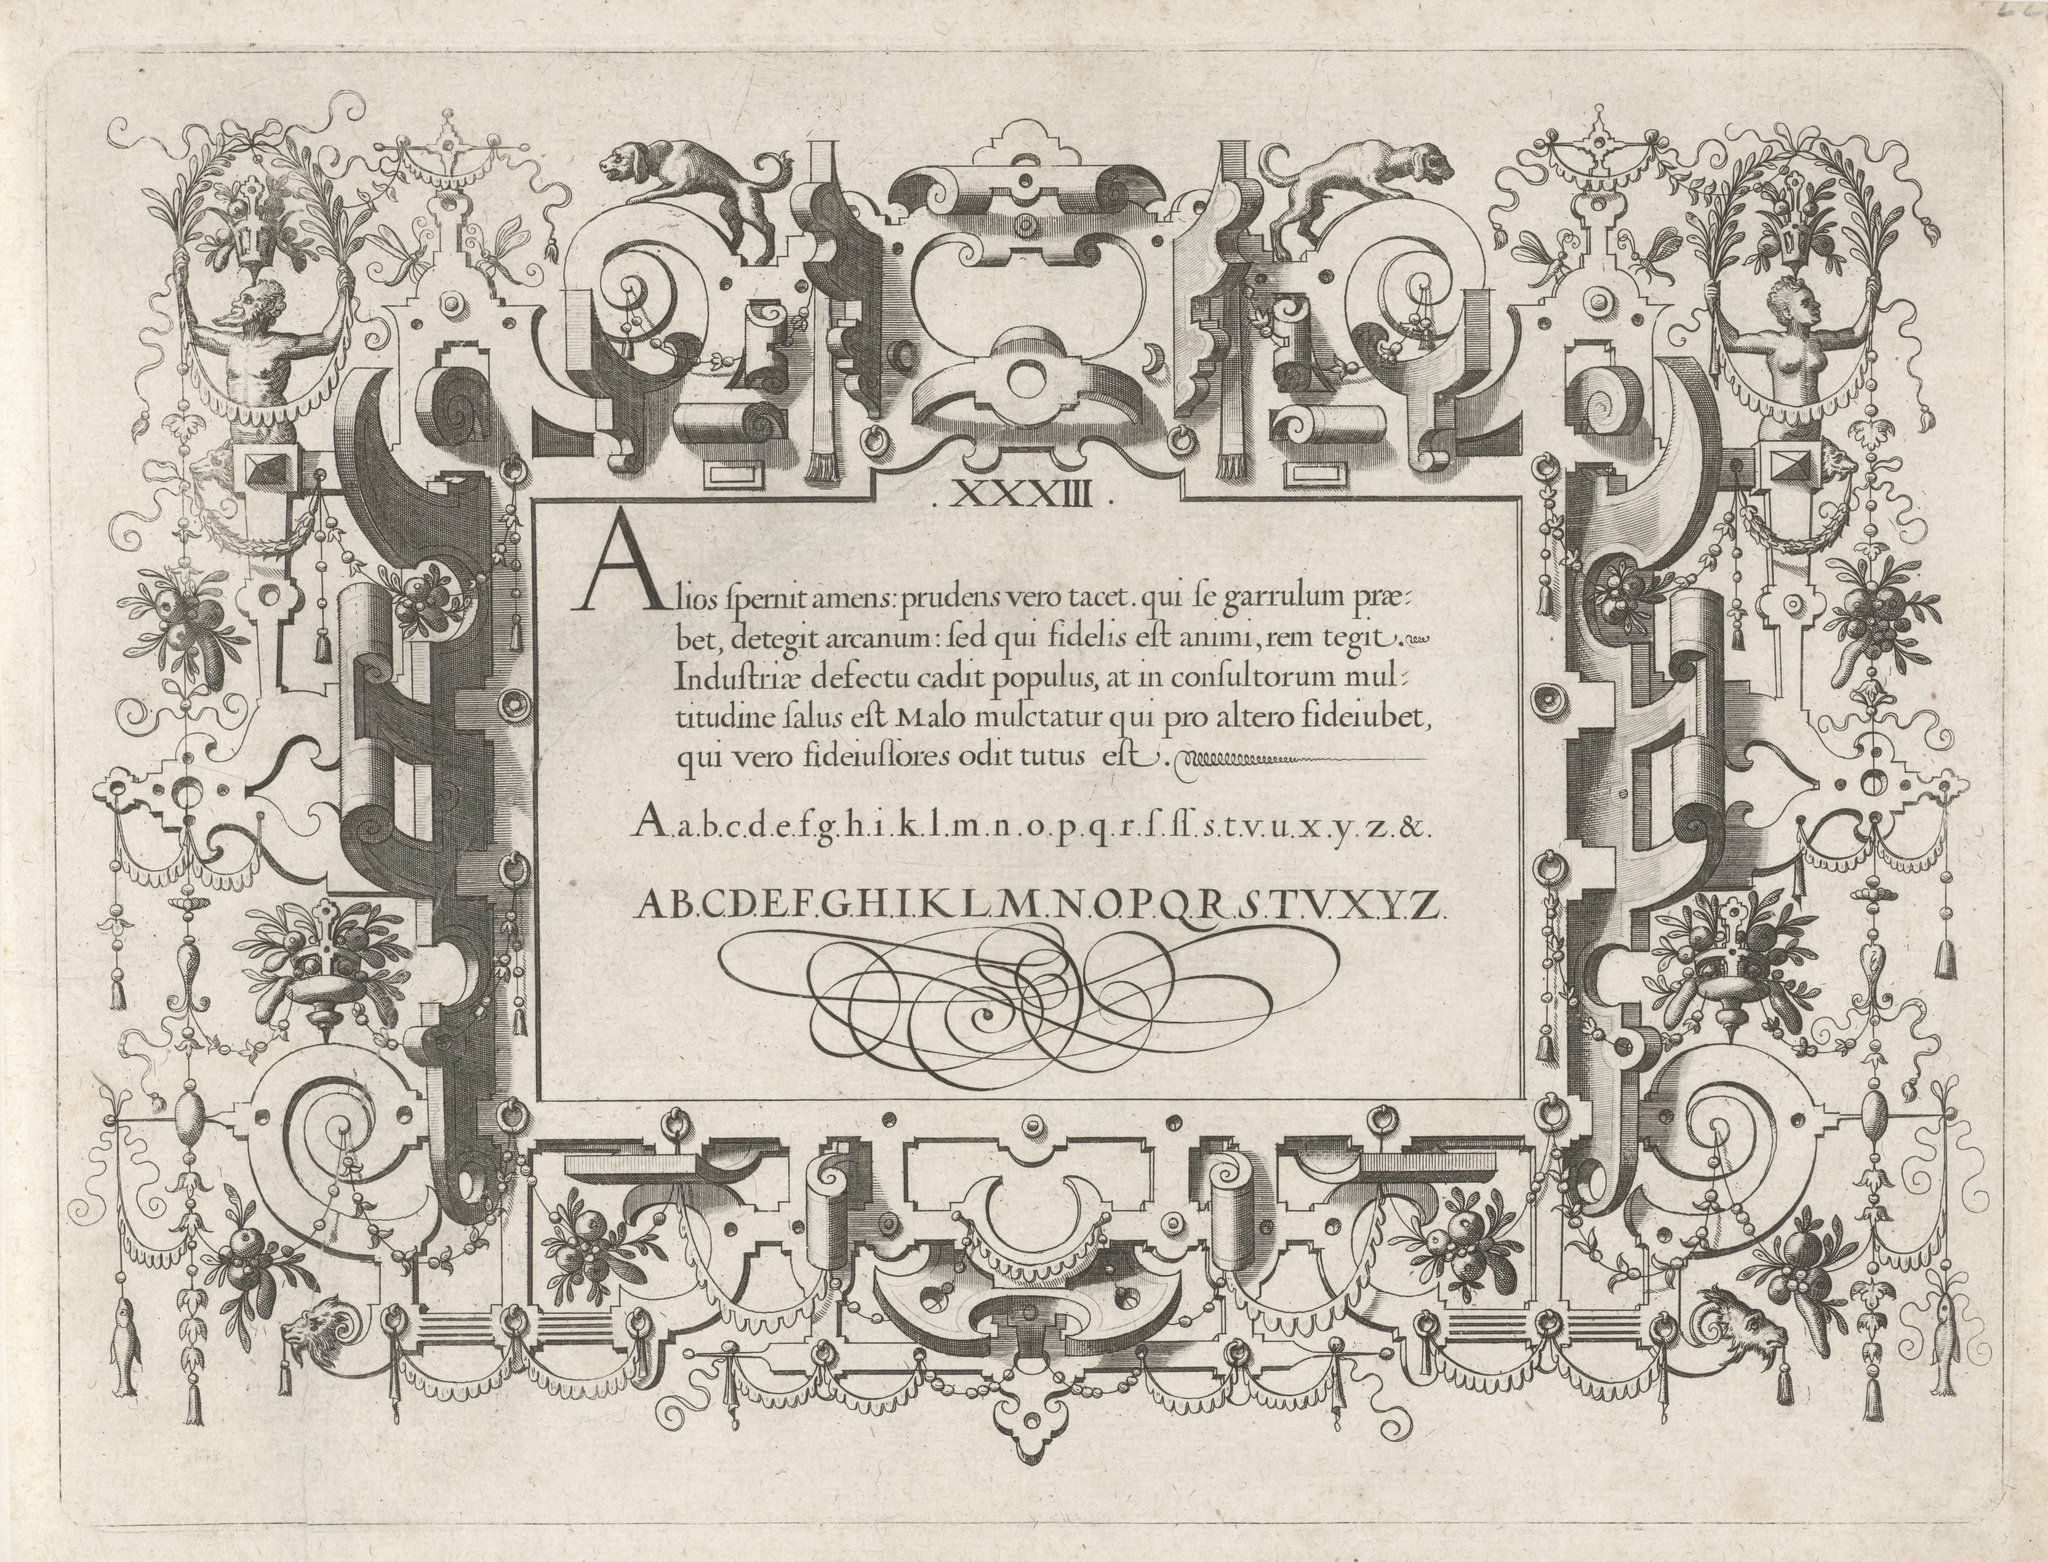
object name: print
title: Exercitatio alphabetica nova et utilissim (...)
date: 1569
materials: paper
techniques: etching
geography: antwerp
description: Blad XXXIII. Uit serie van 21 genummerde cartouches met kalligrafie in een omlijsting van rol- en beslagwerk met grotesken, guirlandes en mascarons.